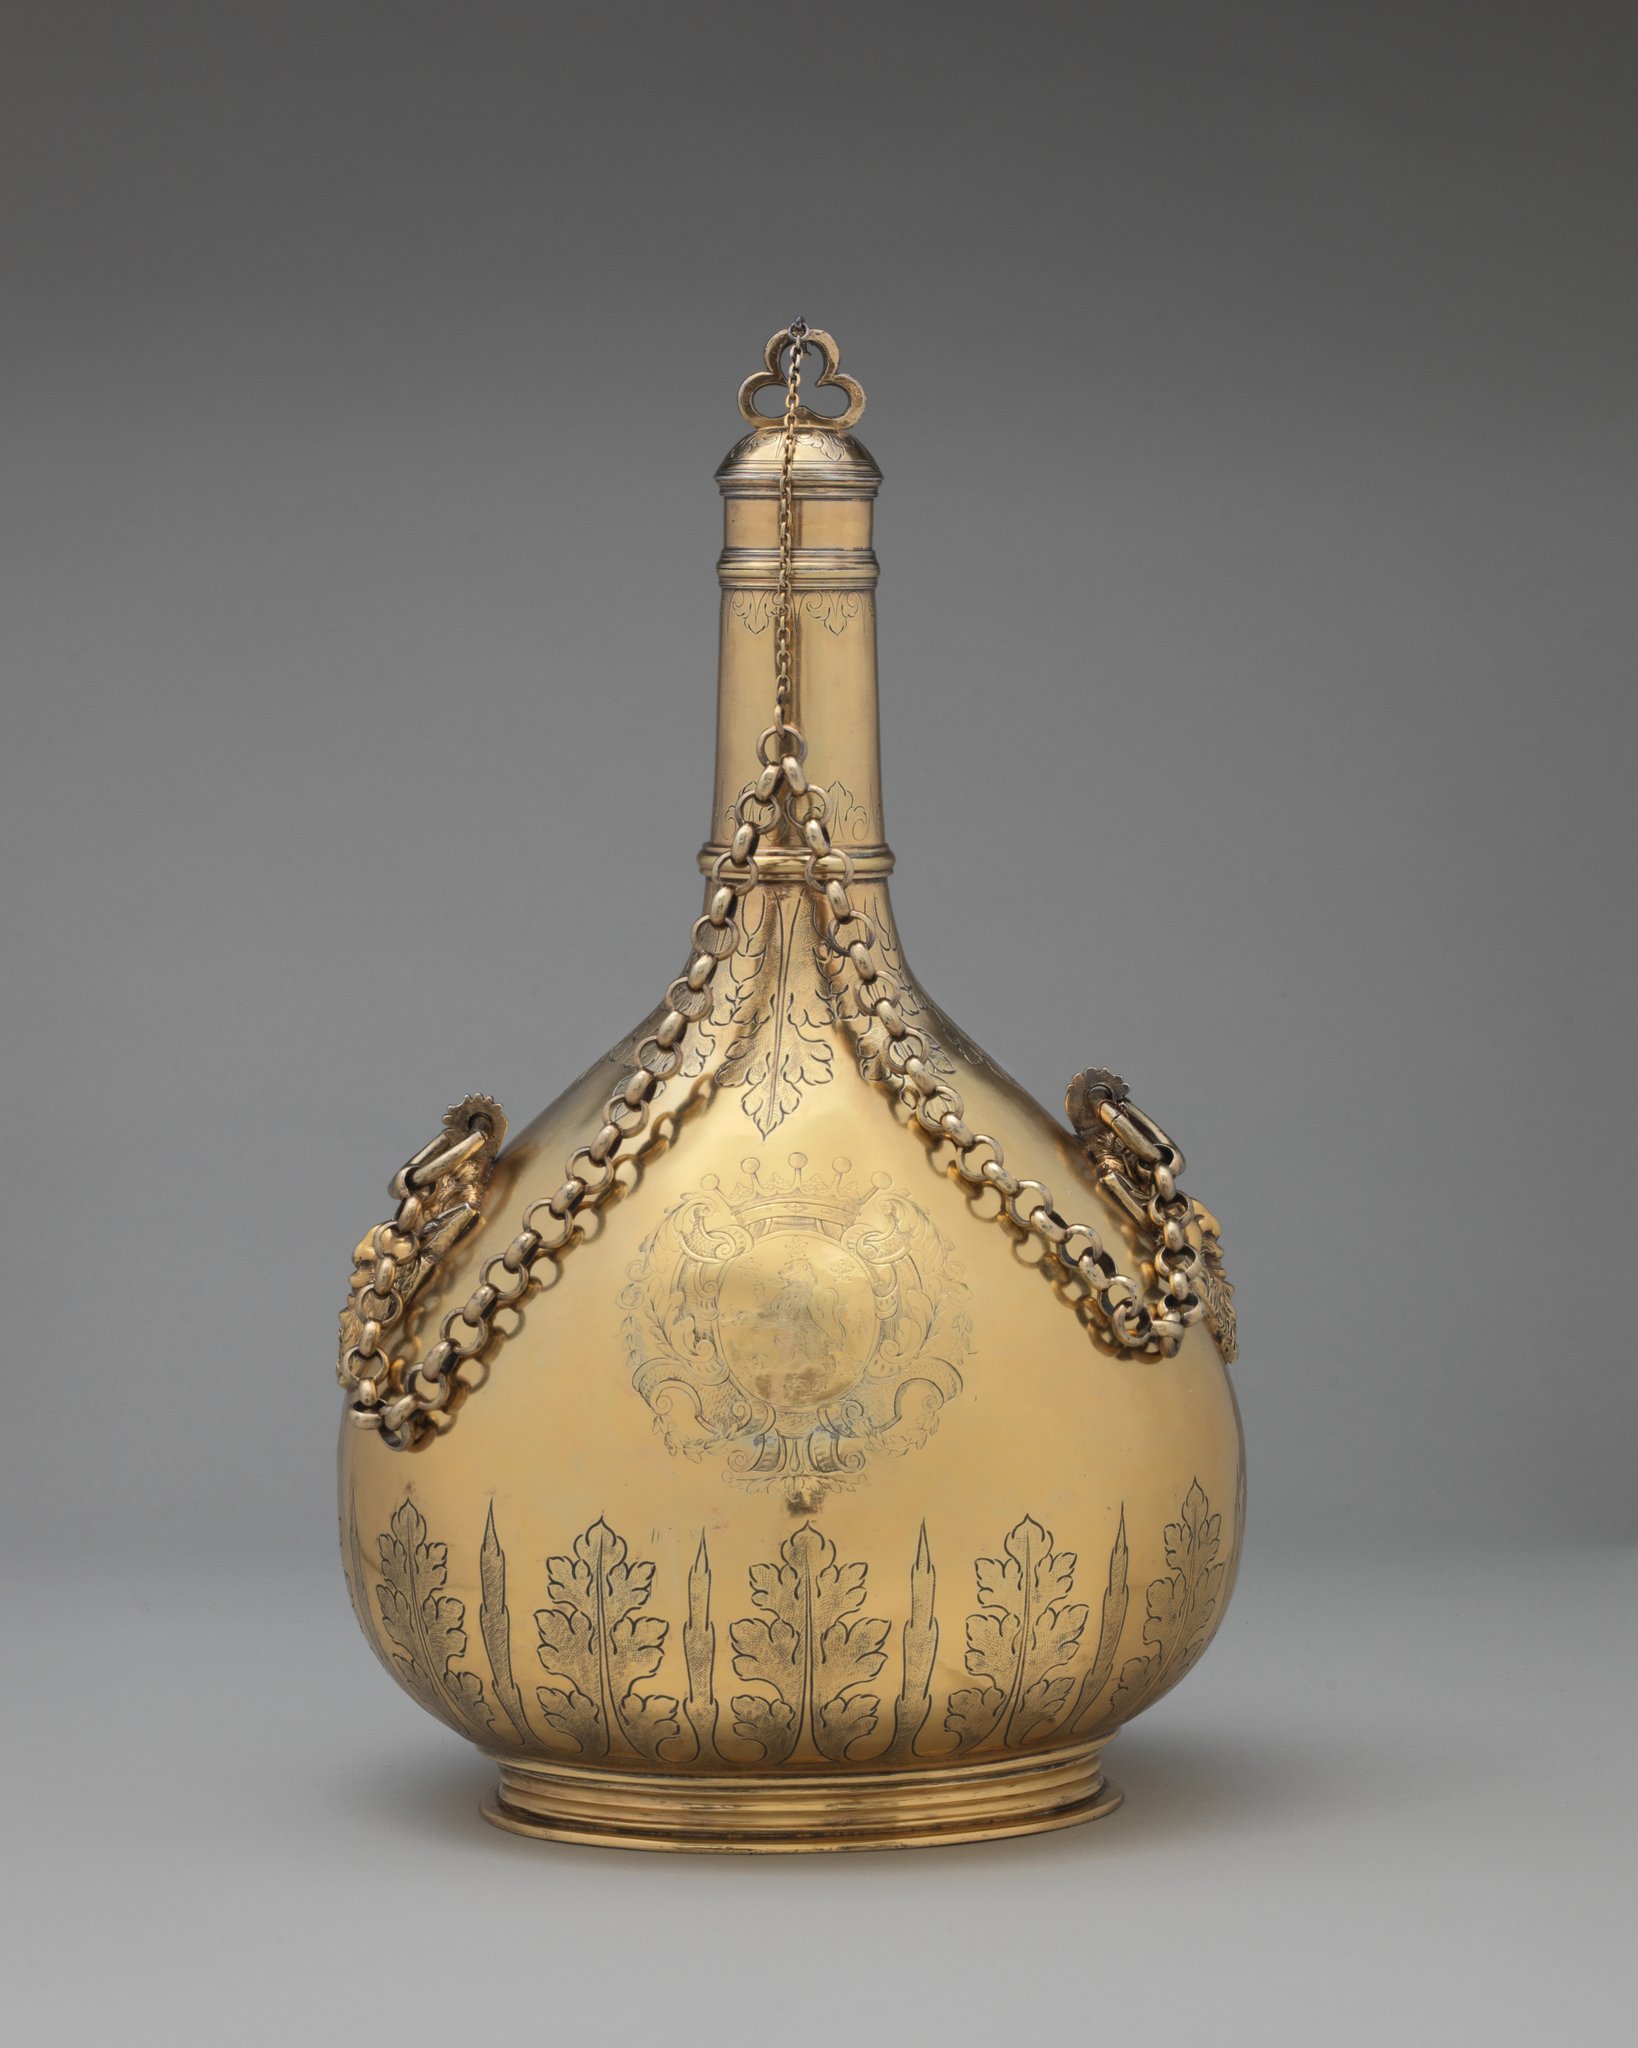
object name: pilgrim bottle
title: Pilgrim bottle (one of a pair)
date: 1690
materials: silver gilt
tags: faces,coat of arms